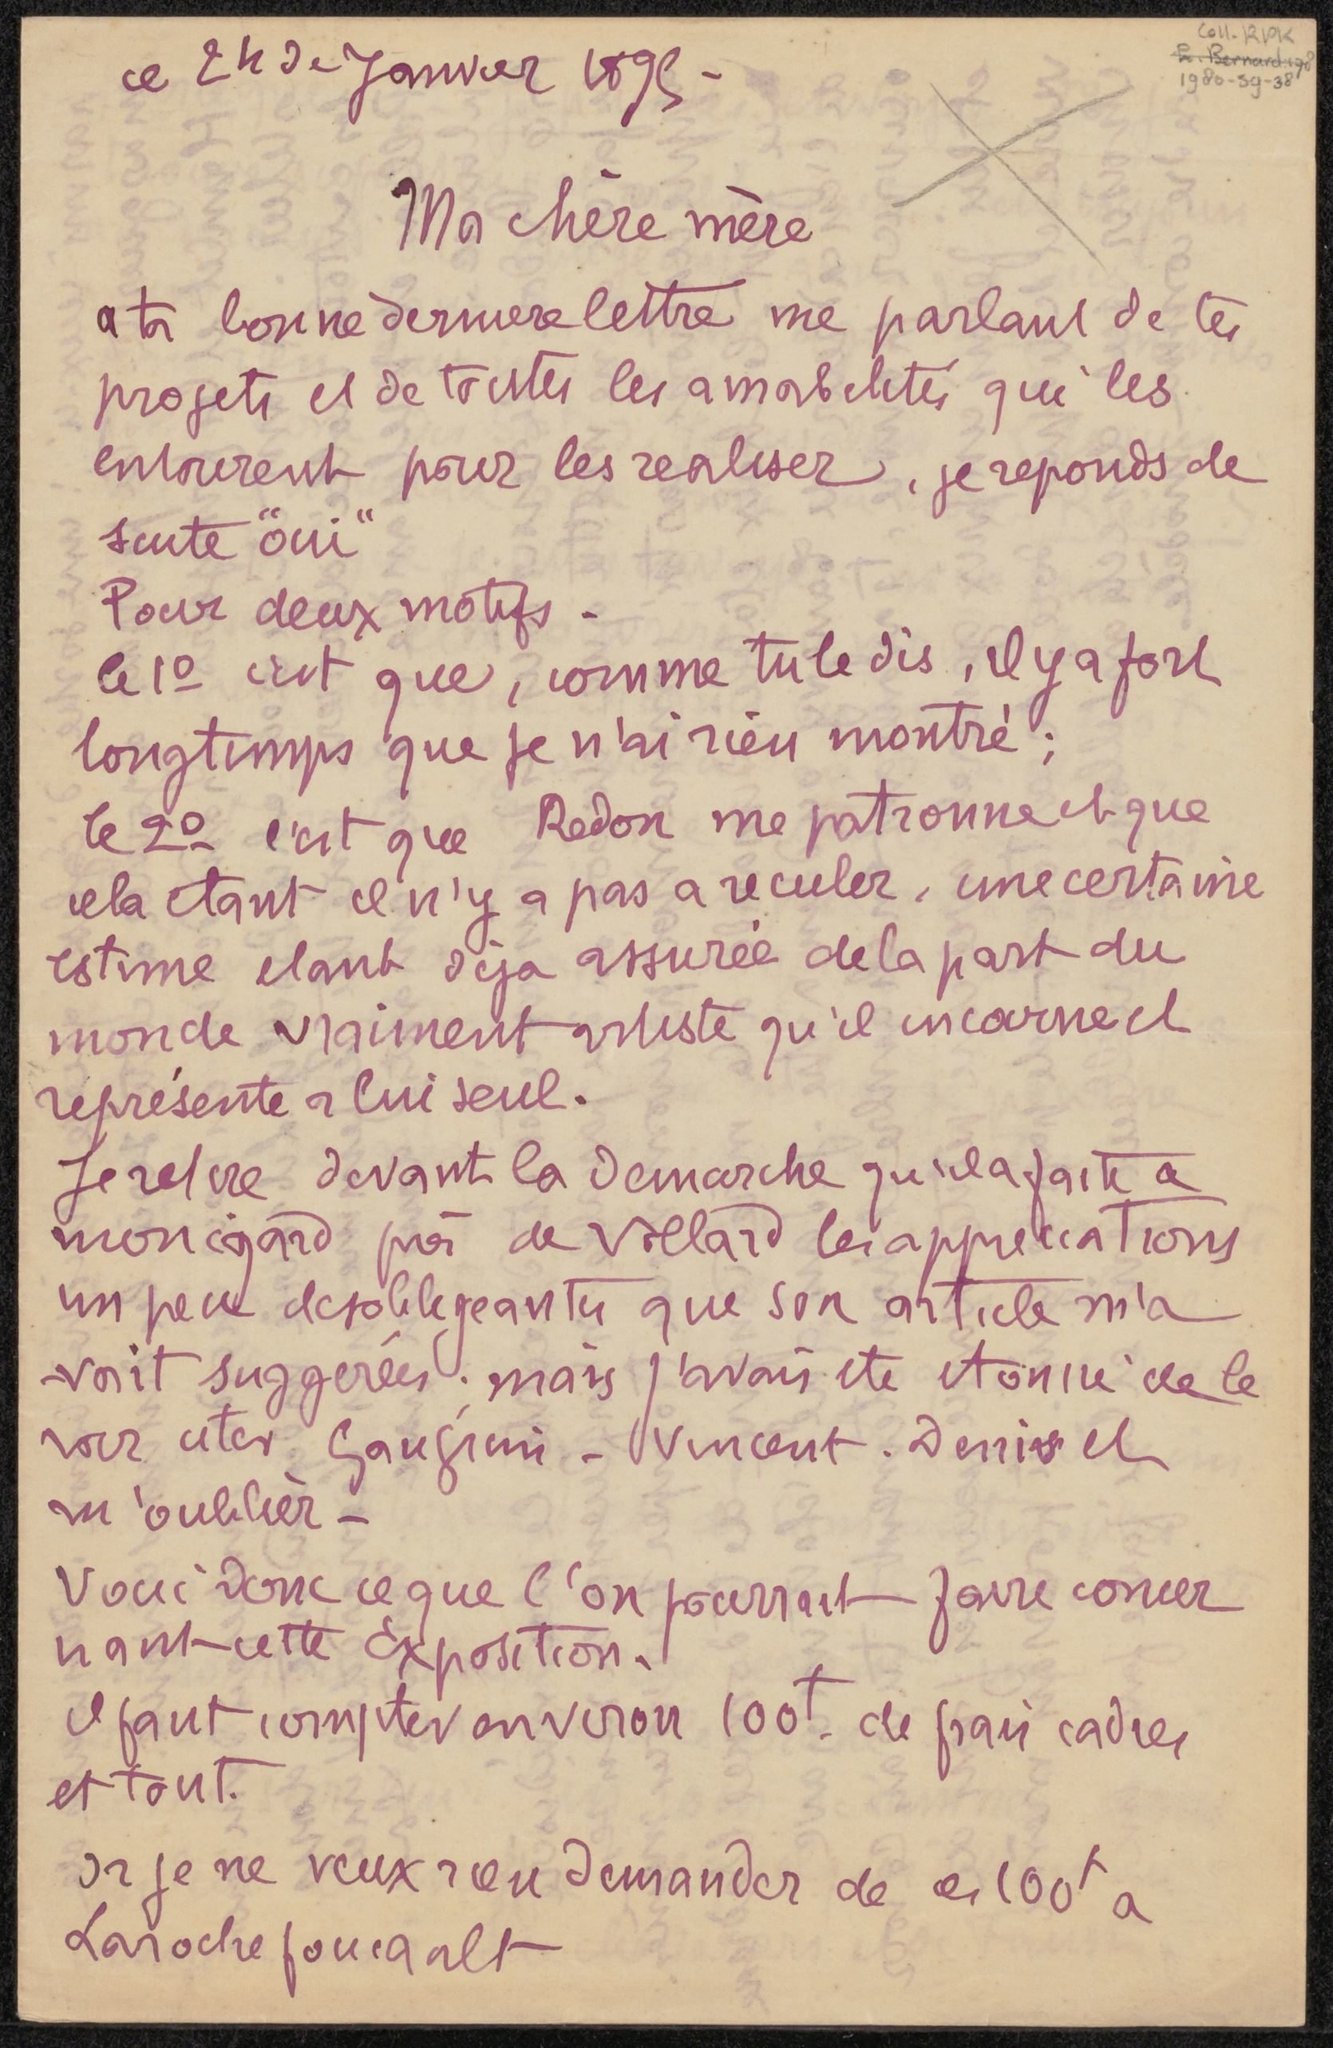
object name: letter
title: Brief aan Héloïse Bernard-Bodin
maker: émile bernard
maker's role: print maker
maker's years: 1868-1941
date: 1895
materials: ink, paper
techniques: pen, writing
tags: héloïse bernard-bodin